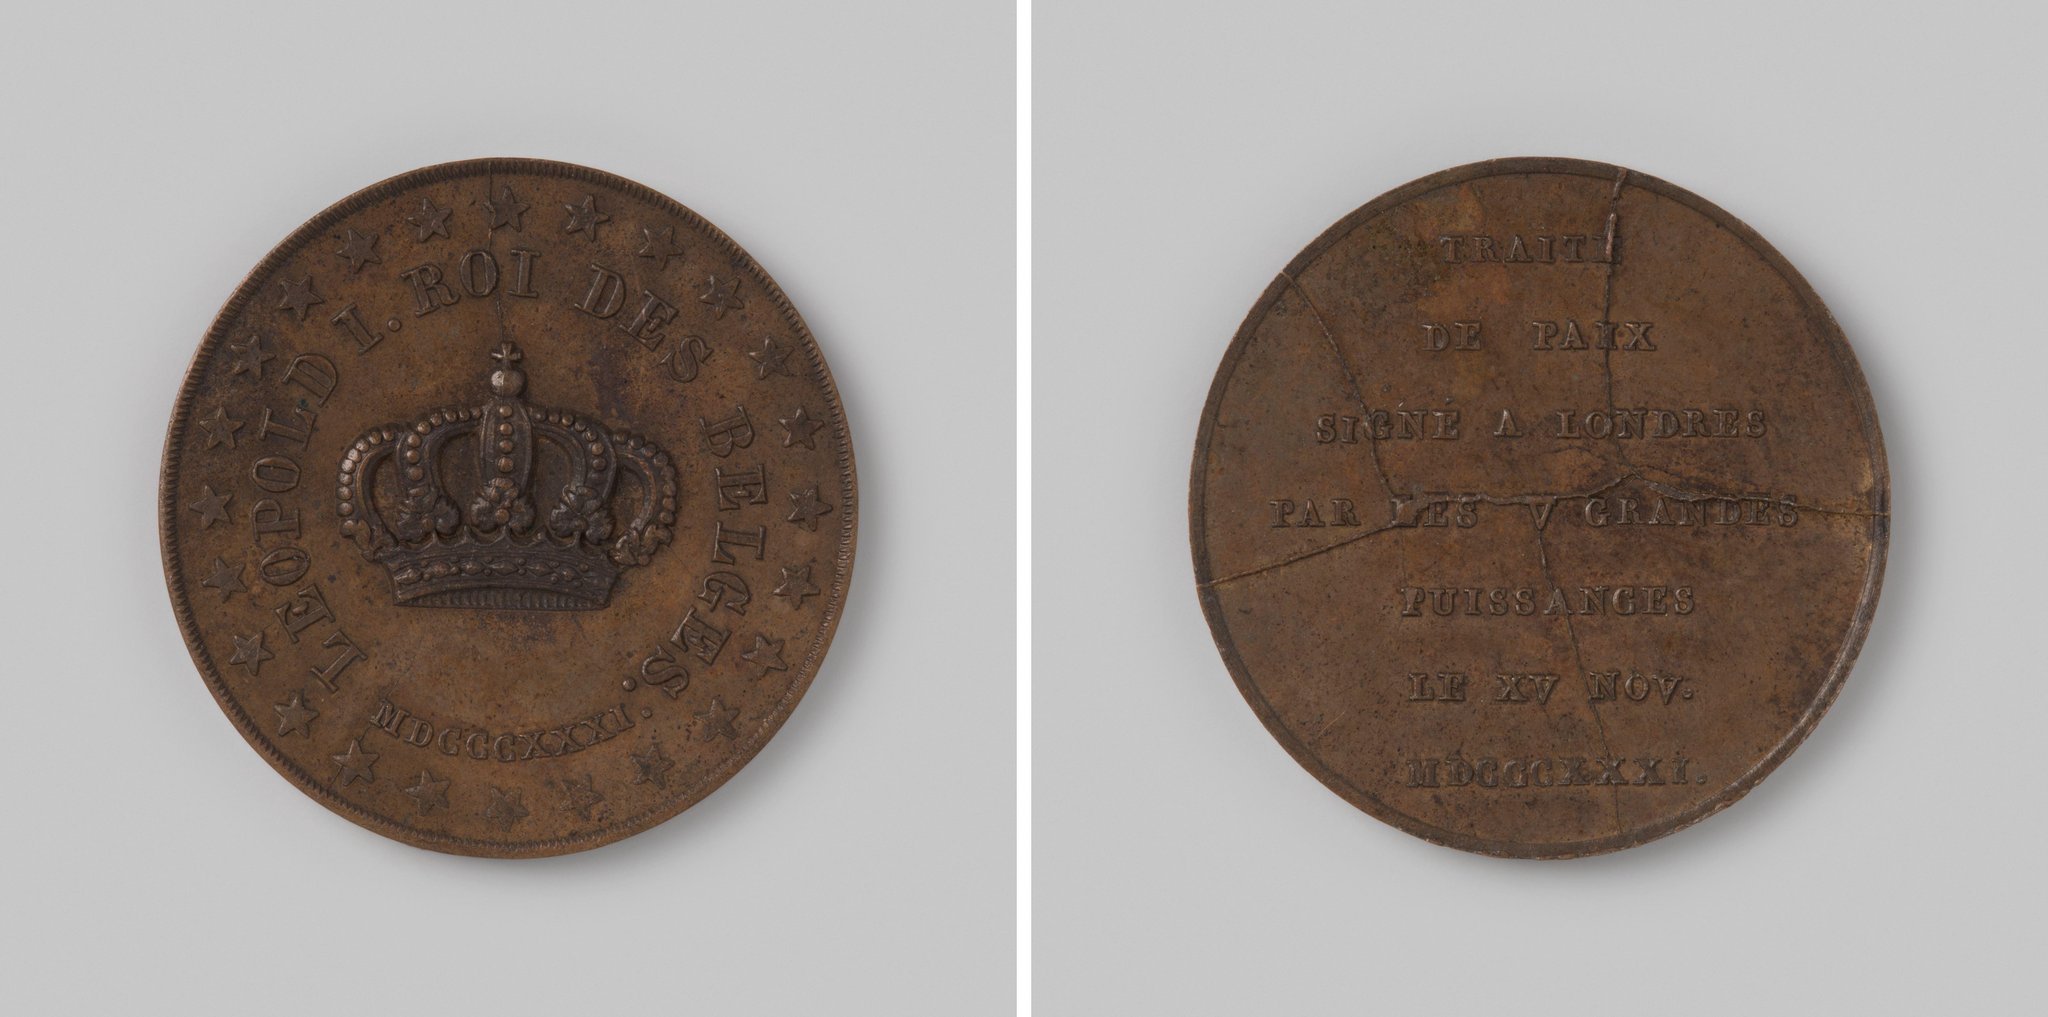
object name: strooipenning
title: Erkenning van de onafhankelijkeid van het koninkrijk België door de XXIV Artikelen van de conferentie van Londen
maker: laurent joseph hart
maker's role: die cutter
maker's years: 1810-1860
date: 1831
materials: bronze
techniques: striking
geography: brussels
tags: laeken, leopold i (koning der belgen), london, belgium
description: Bronzen penning. Voorzijde: kroon binnen omschrift en sterrekrans. Keerzijde: opschrift